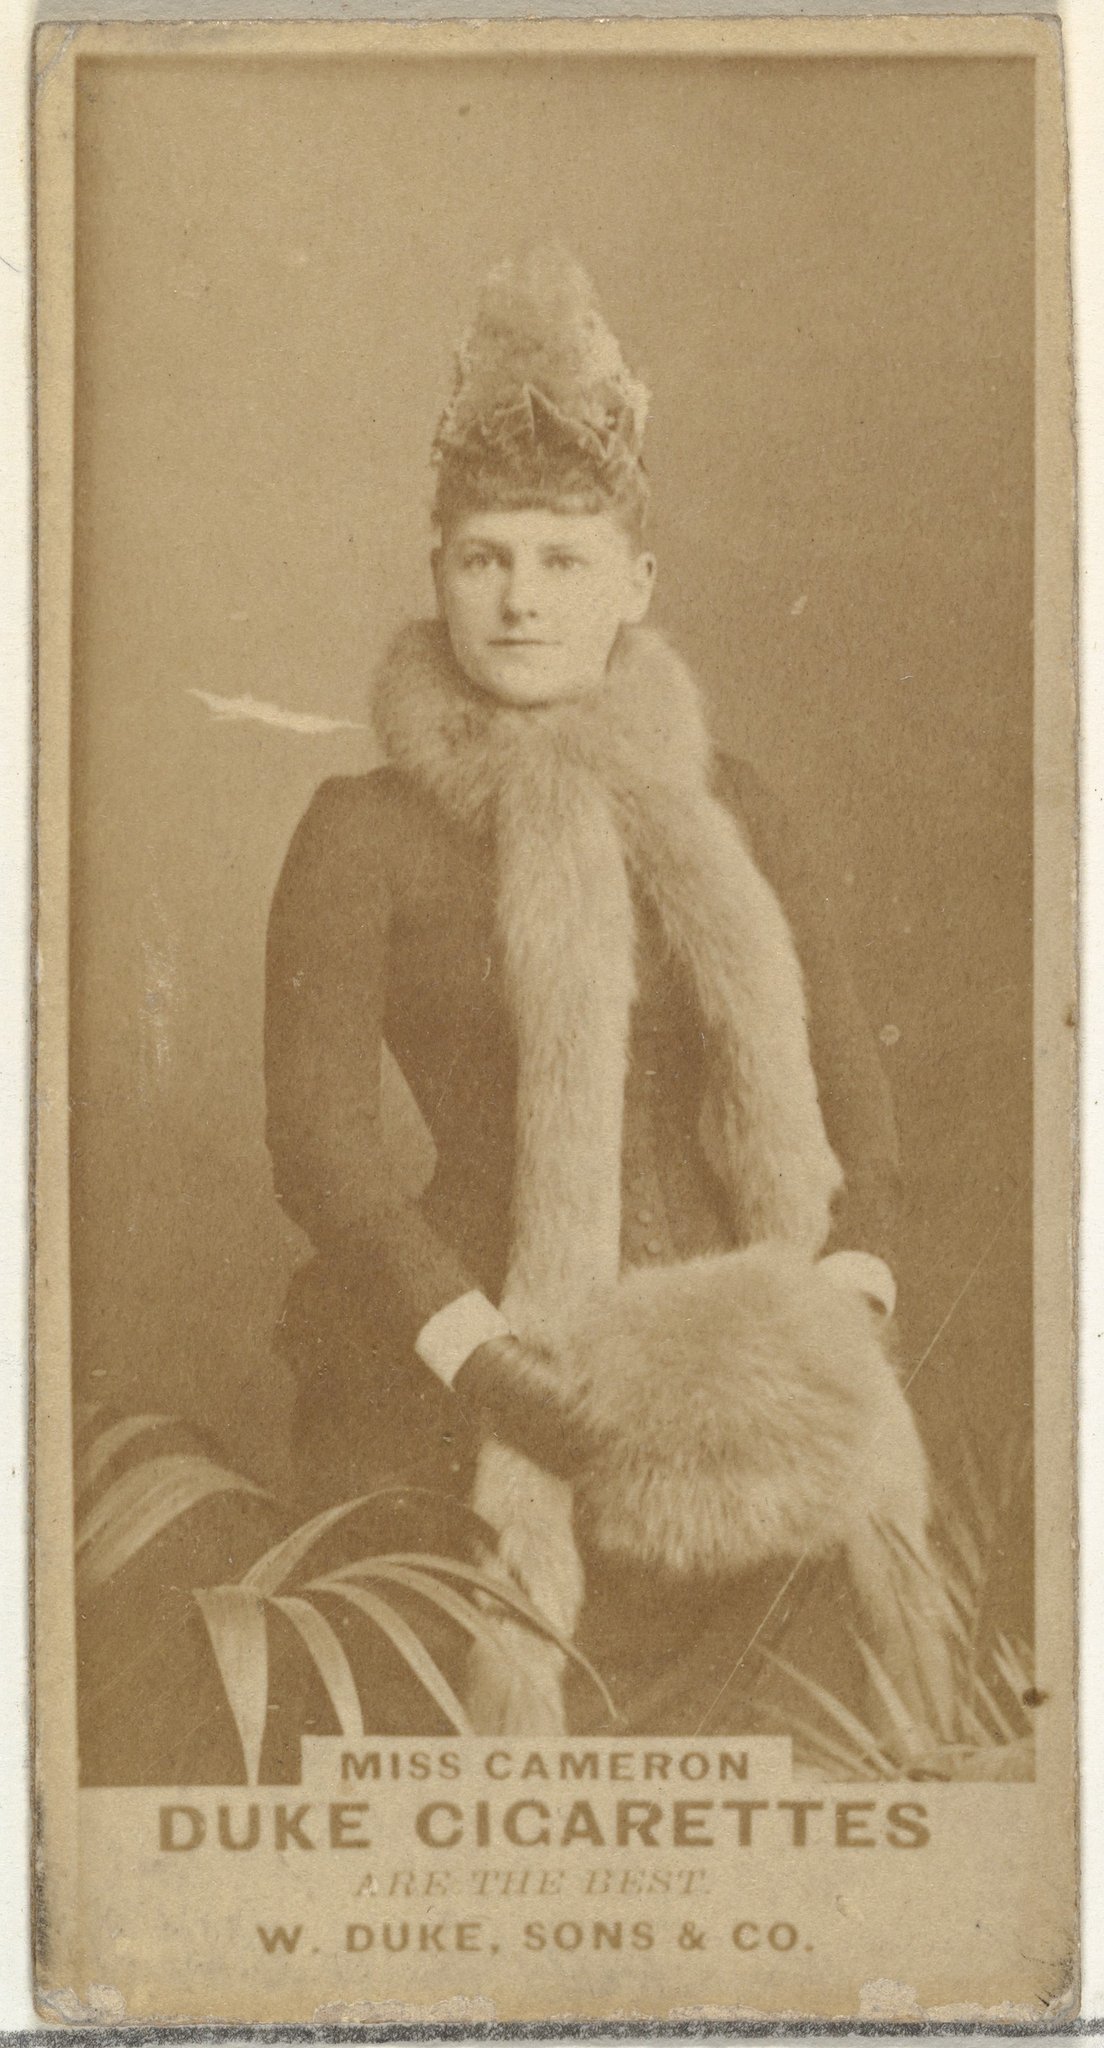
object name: photograph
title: Miss Cameron, from the Actors and Actresses series (N145-7) issued by Duke Sons & Co. to promote Duke Cigarettes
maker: w. duke, sons & co.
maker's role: publisher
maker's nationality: american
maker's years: 1870-1920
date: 1880-1889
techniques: albumen silver print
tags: portraits,women,actresses